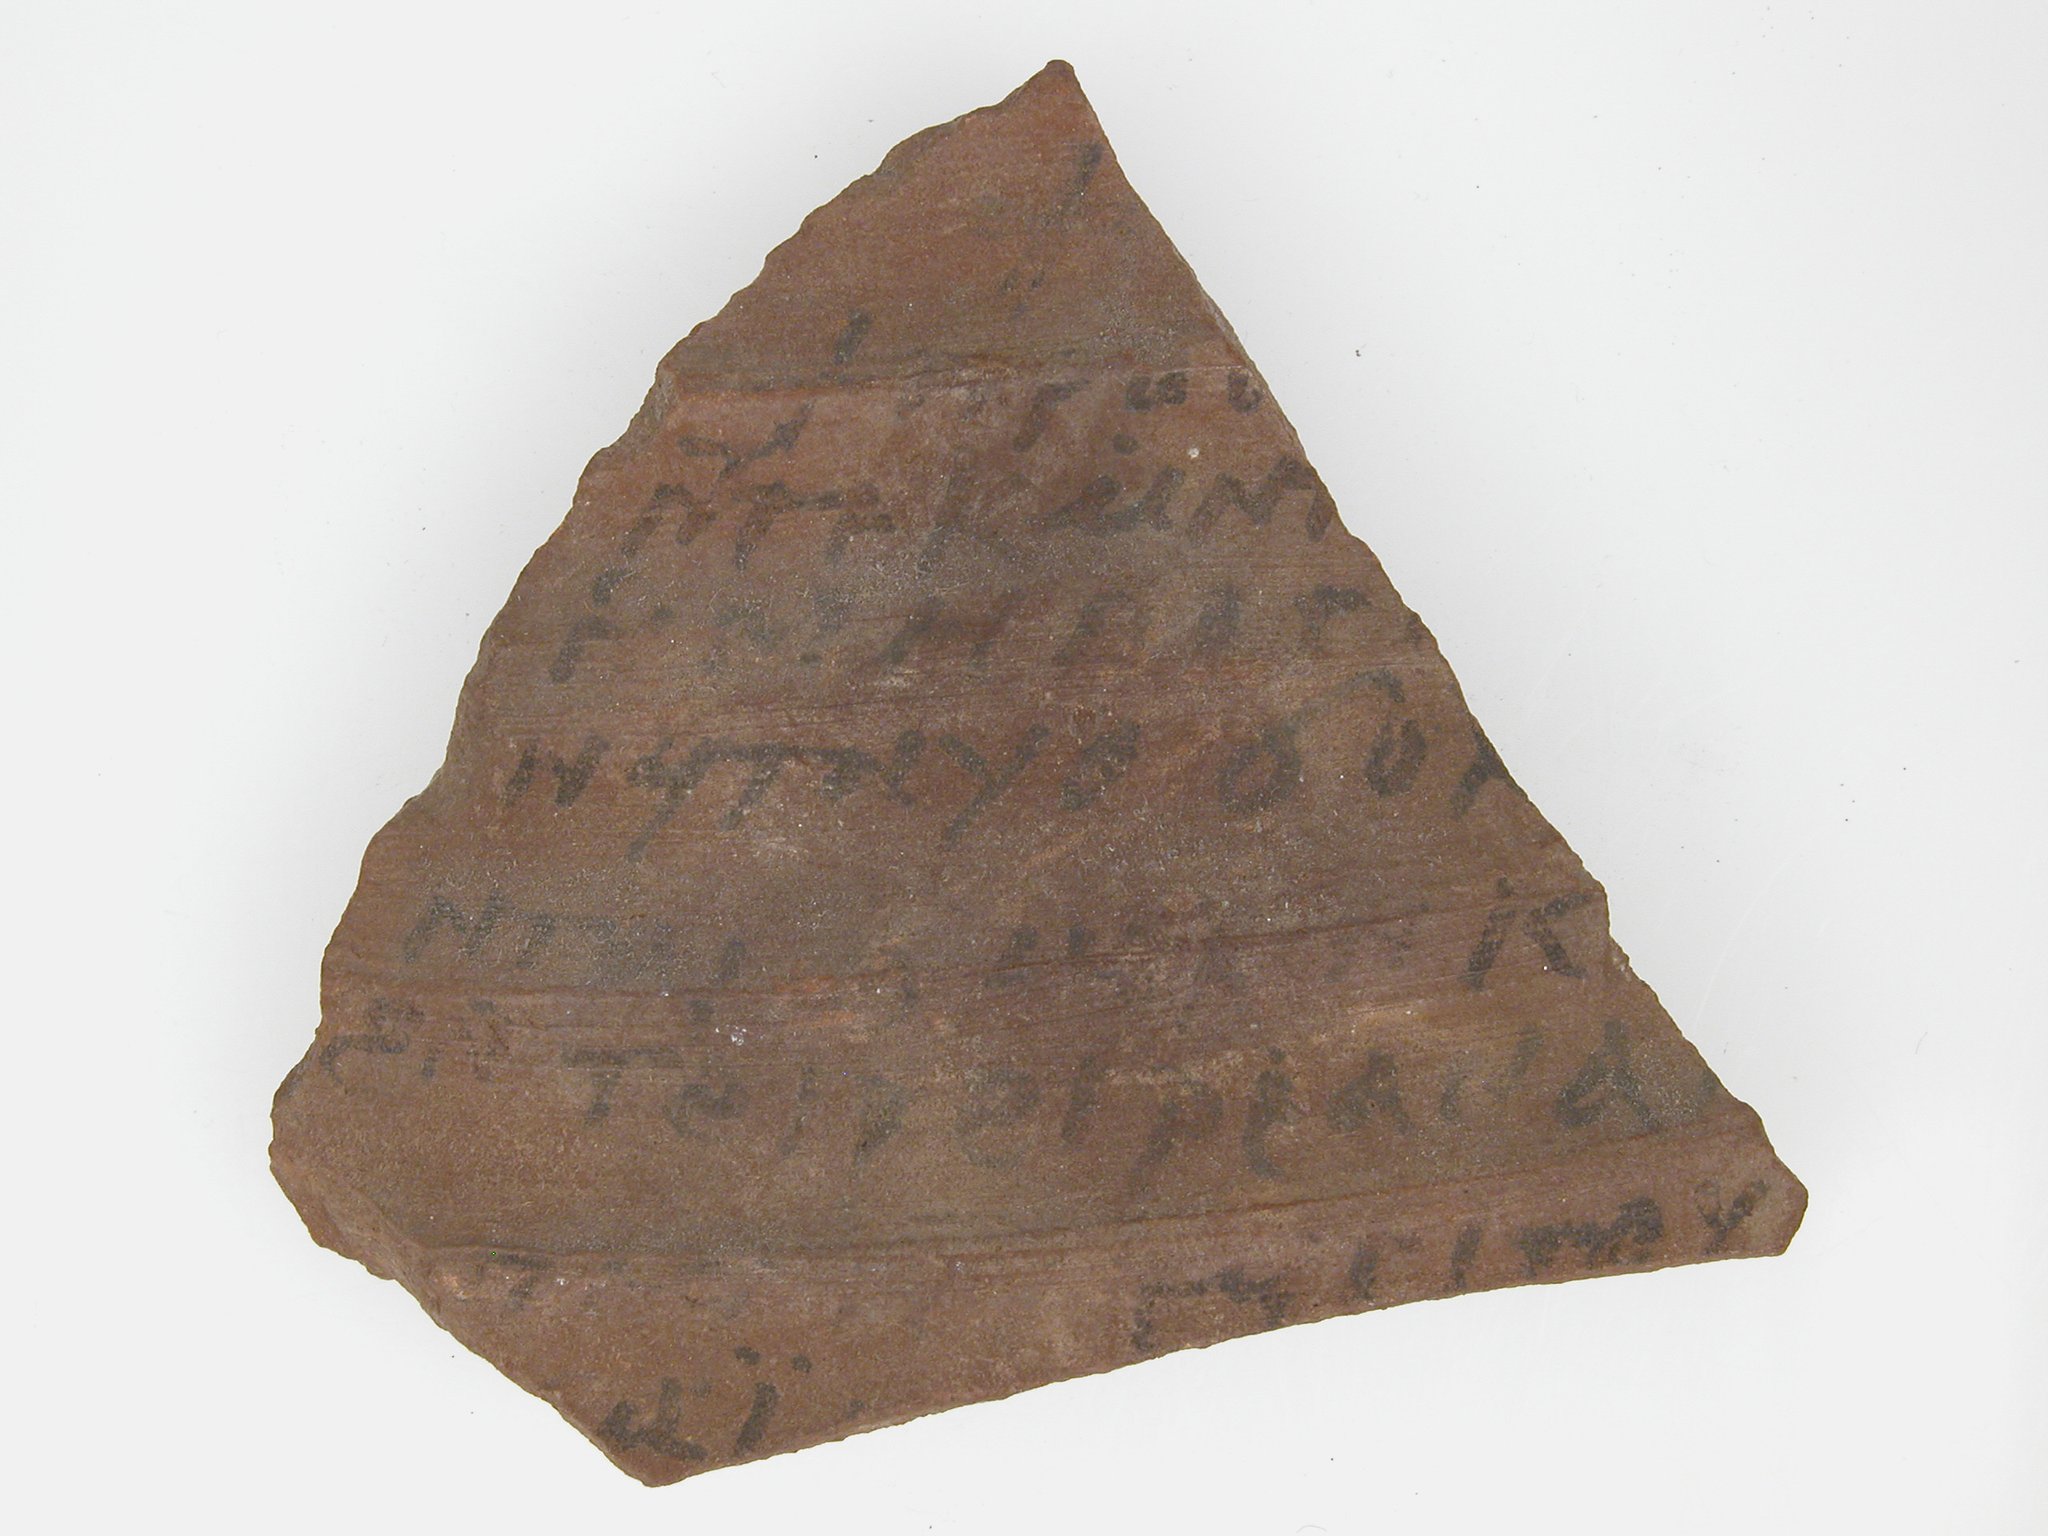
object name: ostrakon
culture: coptic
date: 601-700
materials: ink, pottery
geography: egypt